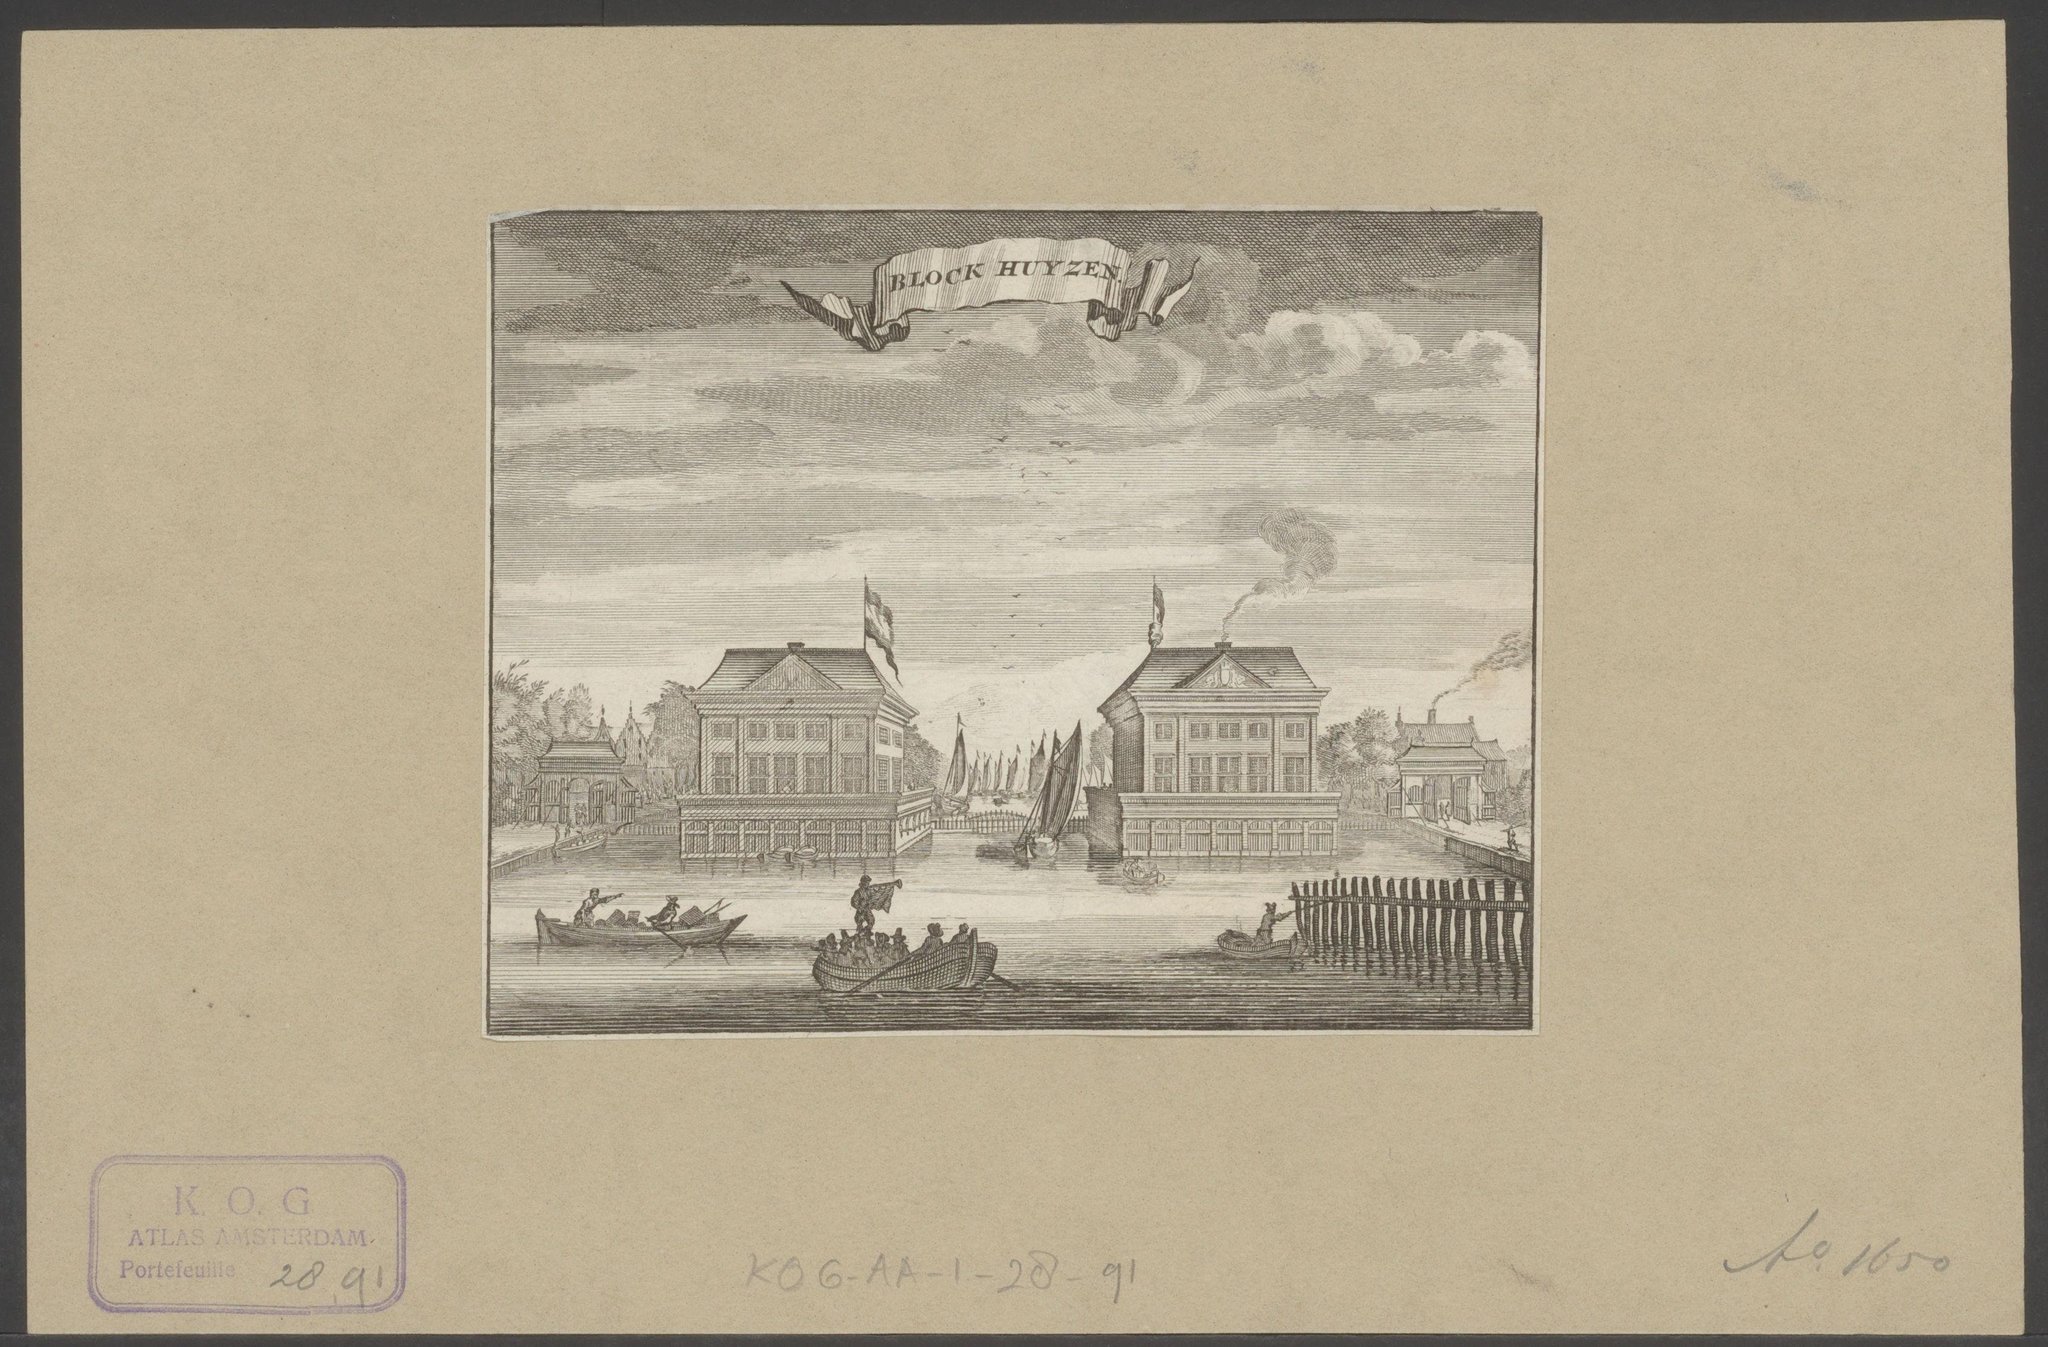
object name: print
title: Block huyzen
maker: Anonymous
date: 1726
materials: paper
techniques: engraving, etching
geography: northern netherlands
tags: rowing-boat, canoe, etc., fortifications, military engineering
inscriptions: collector's mark: Lugt 1641b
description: Huidige staat van prent ook gebruikt in: Commelin, Casparus. Beschryvinge van Amsterdam (…). 2de druk. Amsterdam: Andries van Damme, Johannes Ratelband, weduwe Antony van Aeltwijk en Hermanus Uytwerf, 1726, dl. 2, p. 1148. Eerste staat van prent (zonder opgewerkte lucht) ook gebruikt in: Commelin, Casparus. Beschryvinge van Amsterdam (…). Amsterdam: Abraham Wolfgang, Gillis Janssonius van Waesberge of Johannes Janssonius van Waesberge, Hendrick Boom of weduwe Dirk Boom, Abraham van Sanderen en Rembertus Goethals, 1693, dl. 2, p. 1148. En in: Commelin, Casparus. Beschryvinge van Amsterdam (…). Amsterdam: weduwe Aart Dircksz Oossaan, 1694, dl. 2, p. 1148.